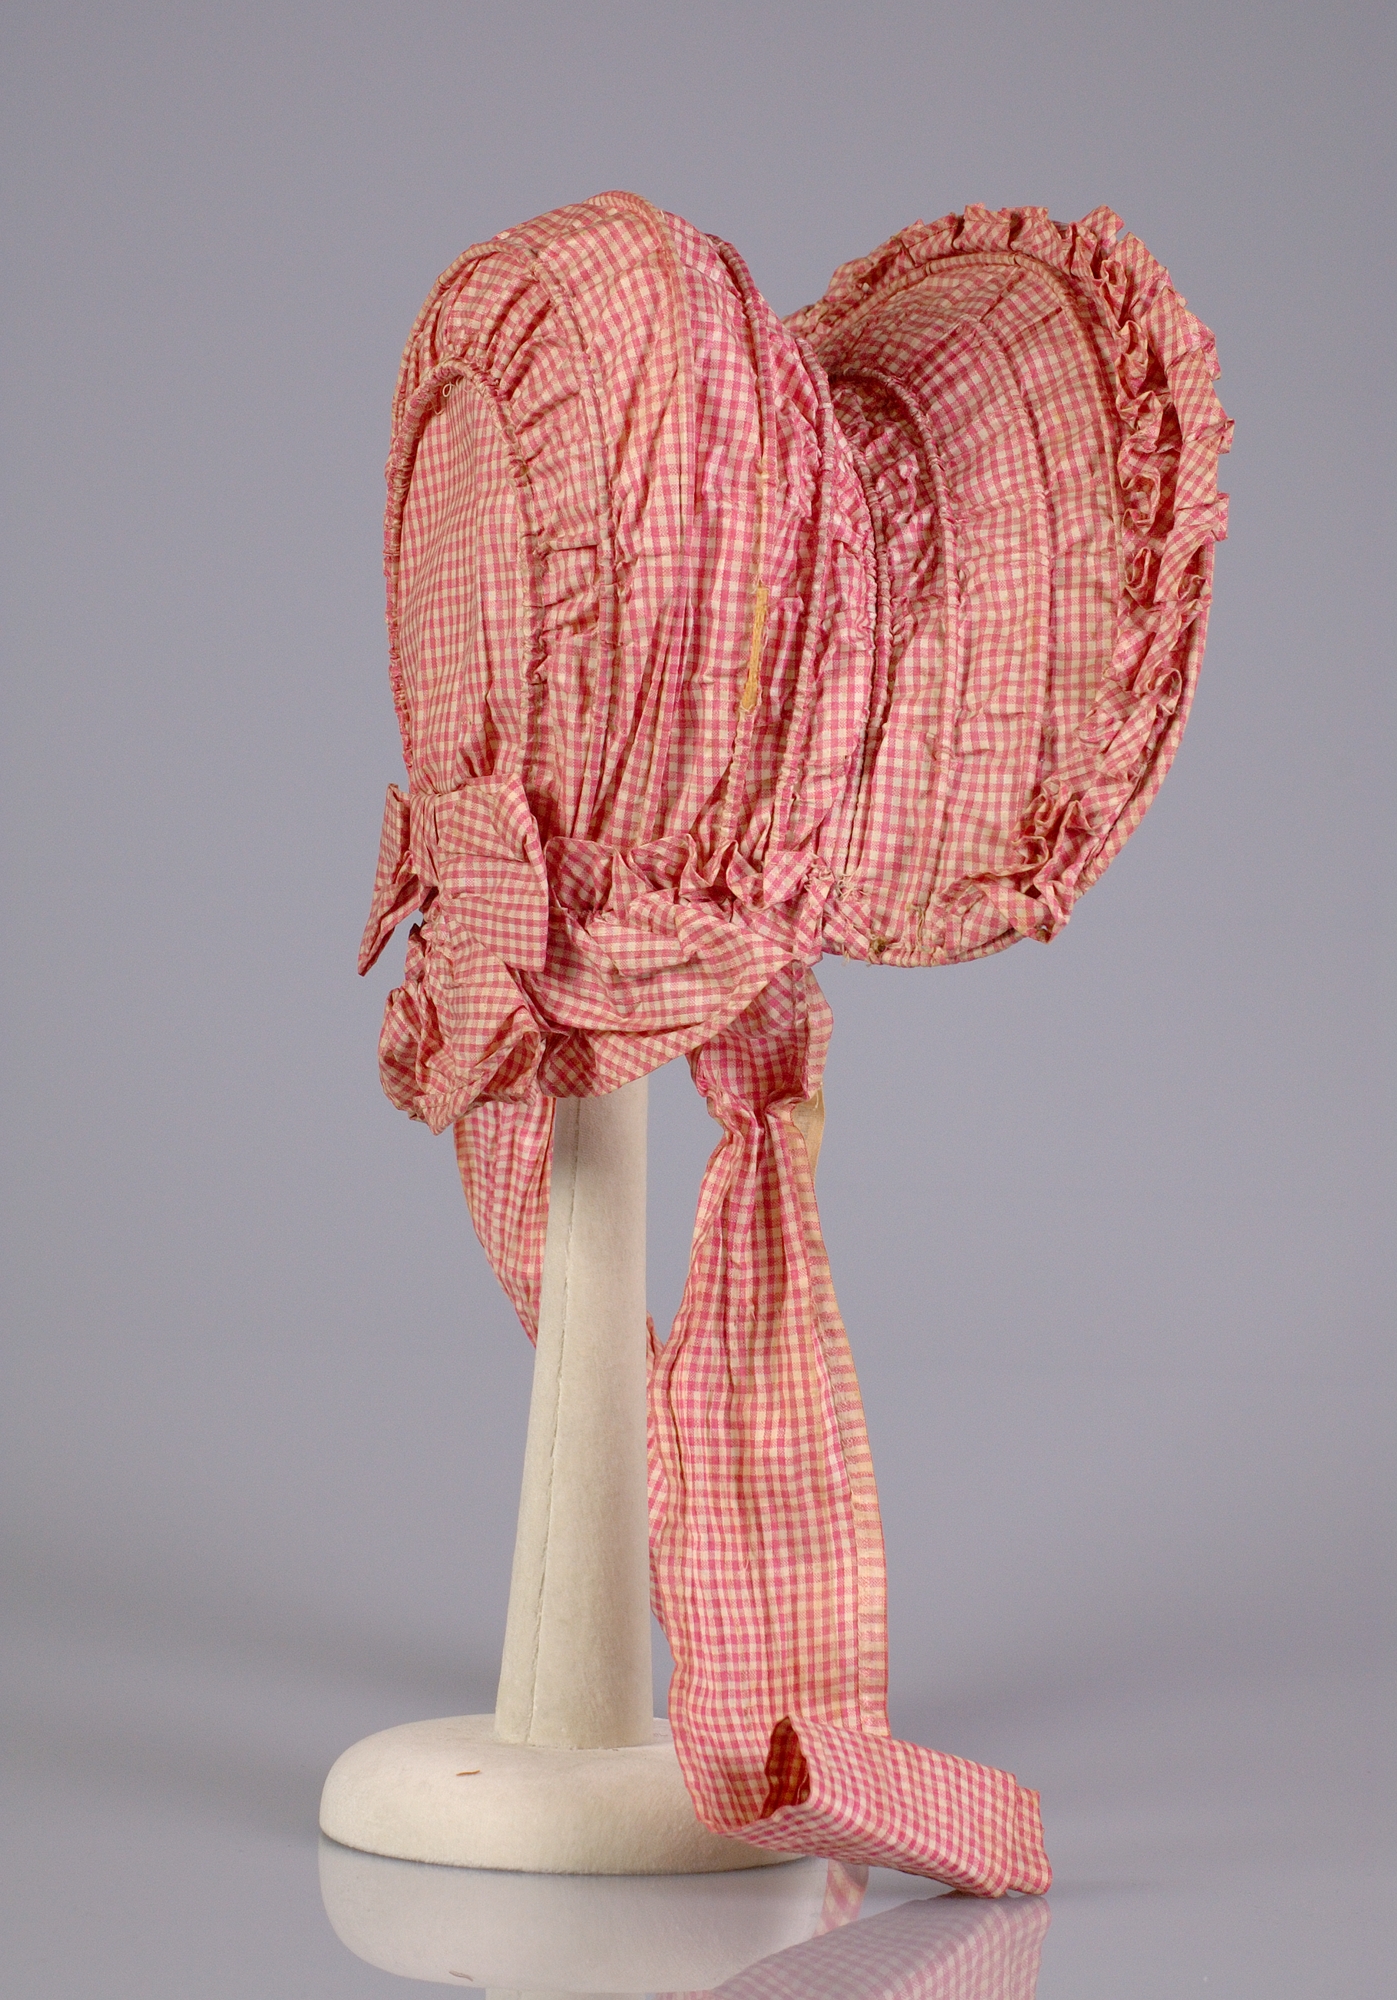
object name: bonnet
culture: american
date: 1860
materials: cotton